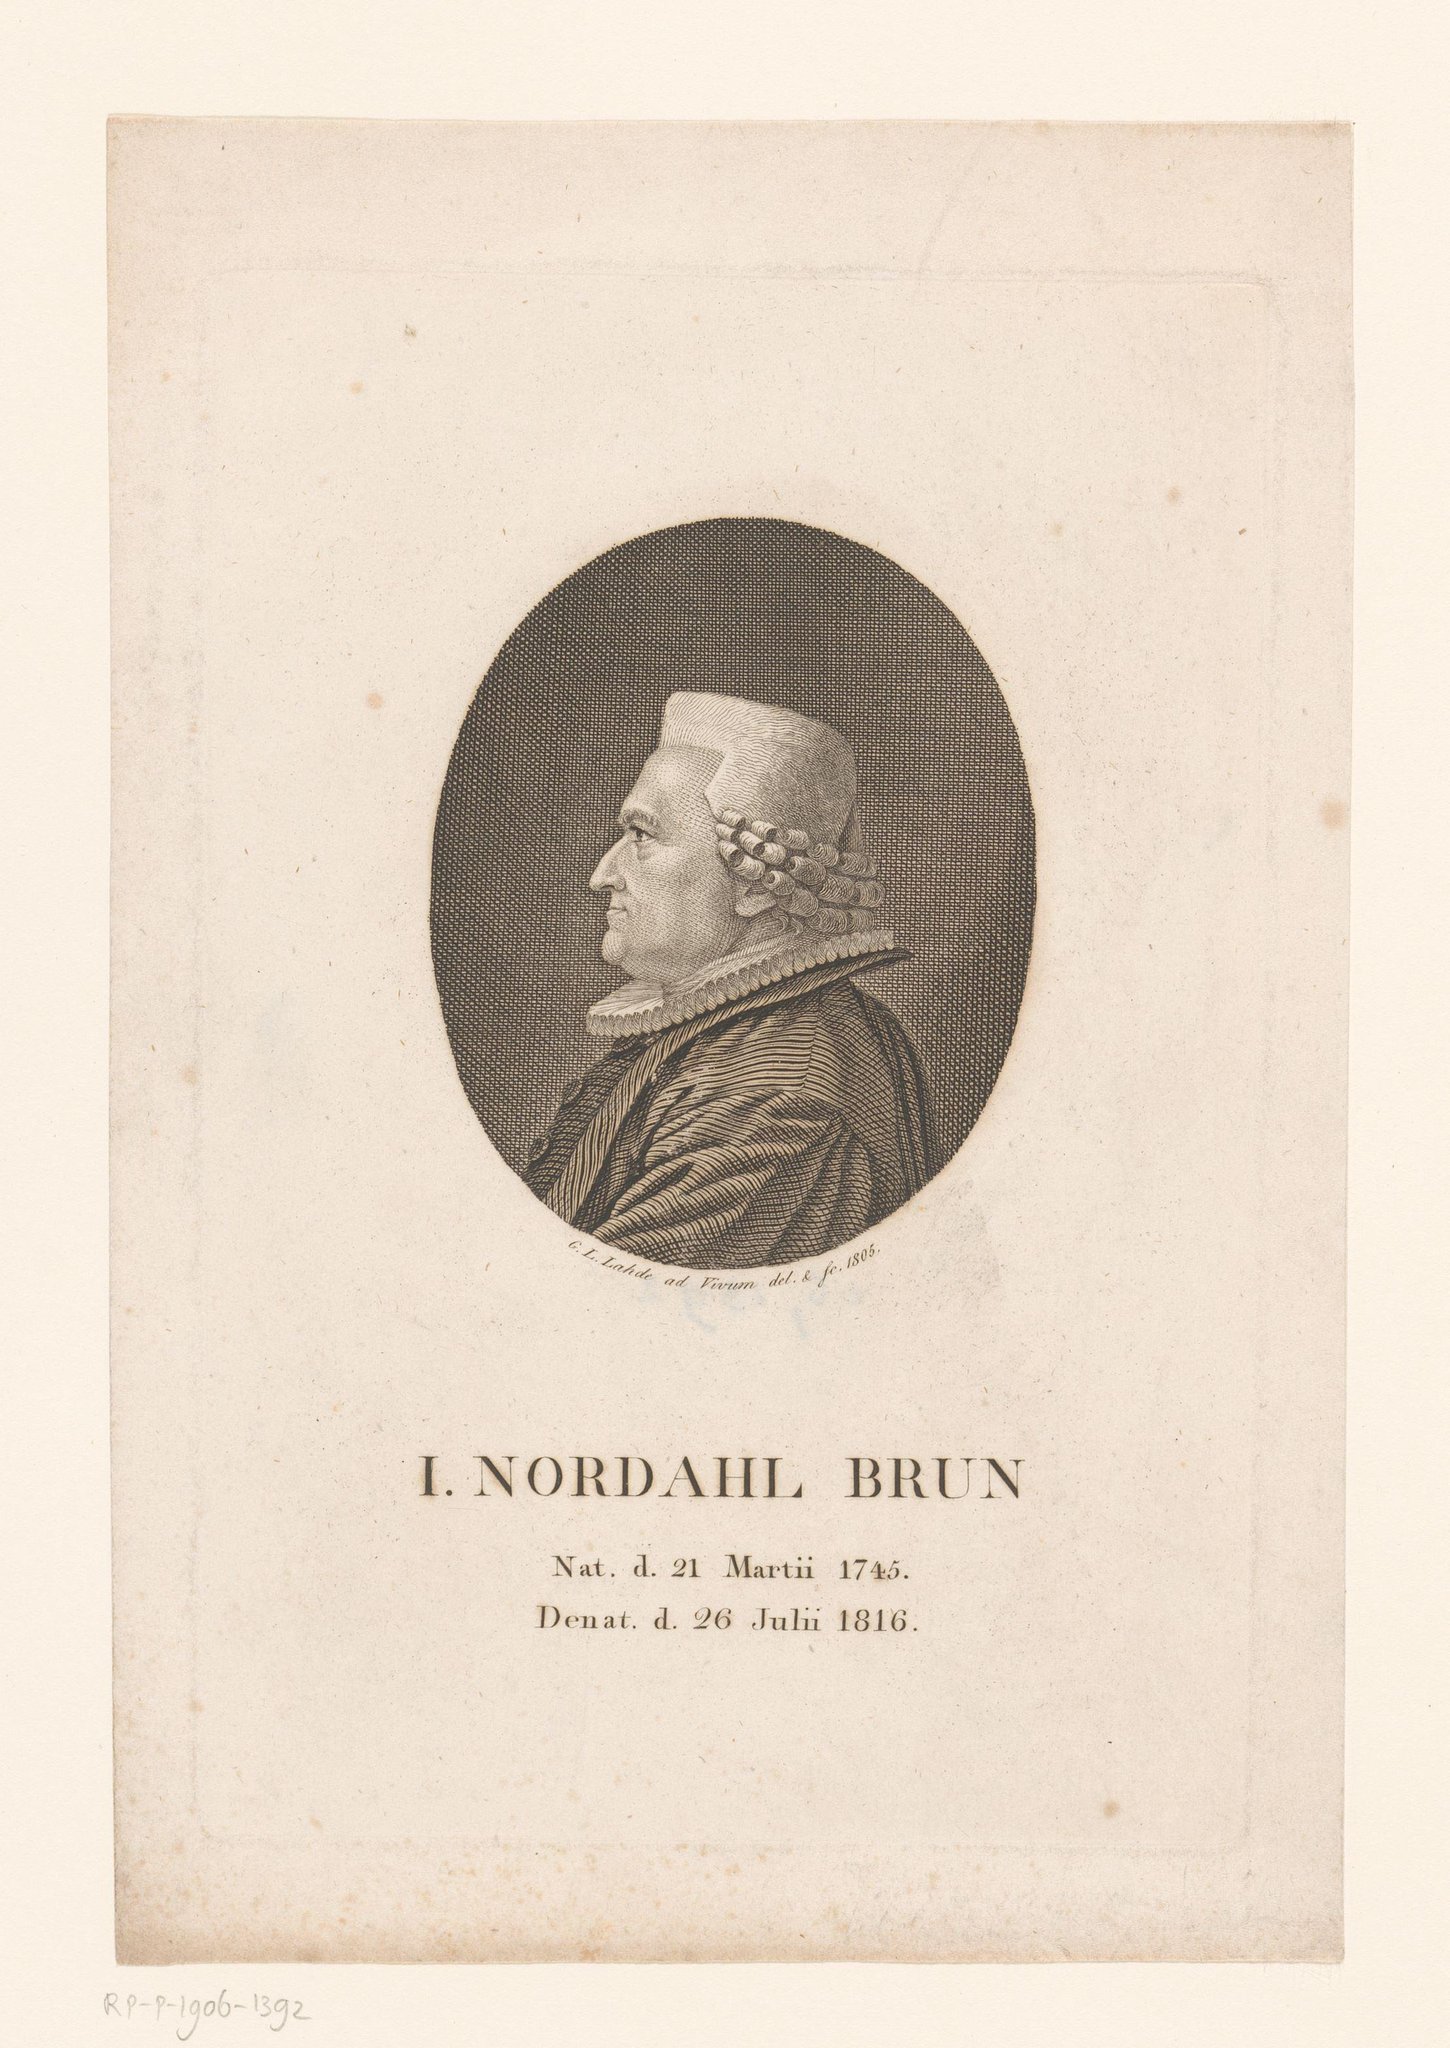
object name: print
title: Portret van Johan Nordahl Brun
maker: gerhard ludwig lahde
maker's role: goldsmith, print maker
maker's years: 1765-1833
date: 1805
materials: paper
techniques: engraving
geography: denmark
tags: historical persons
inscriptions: collector's mark: Lugt 2228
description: Portret van Johan Nordhal Brun, buste in ovaal, naar links. Schrijver en bisschop in Bergen.